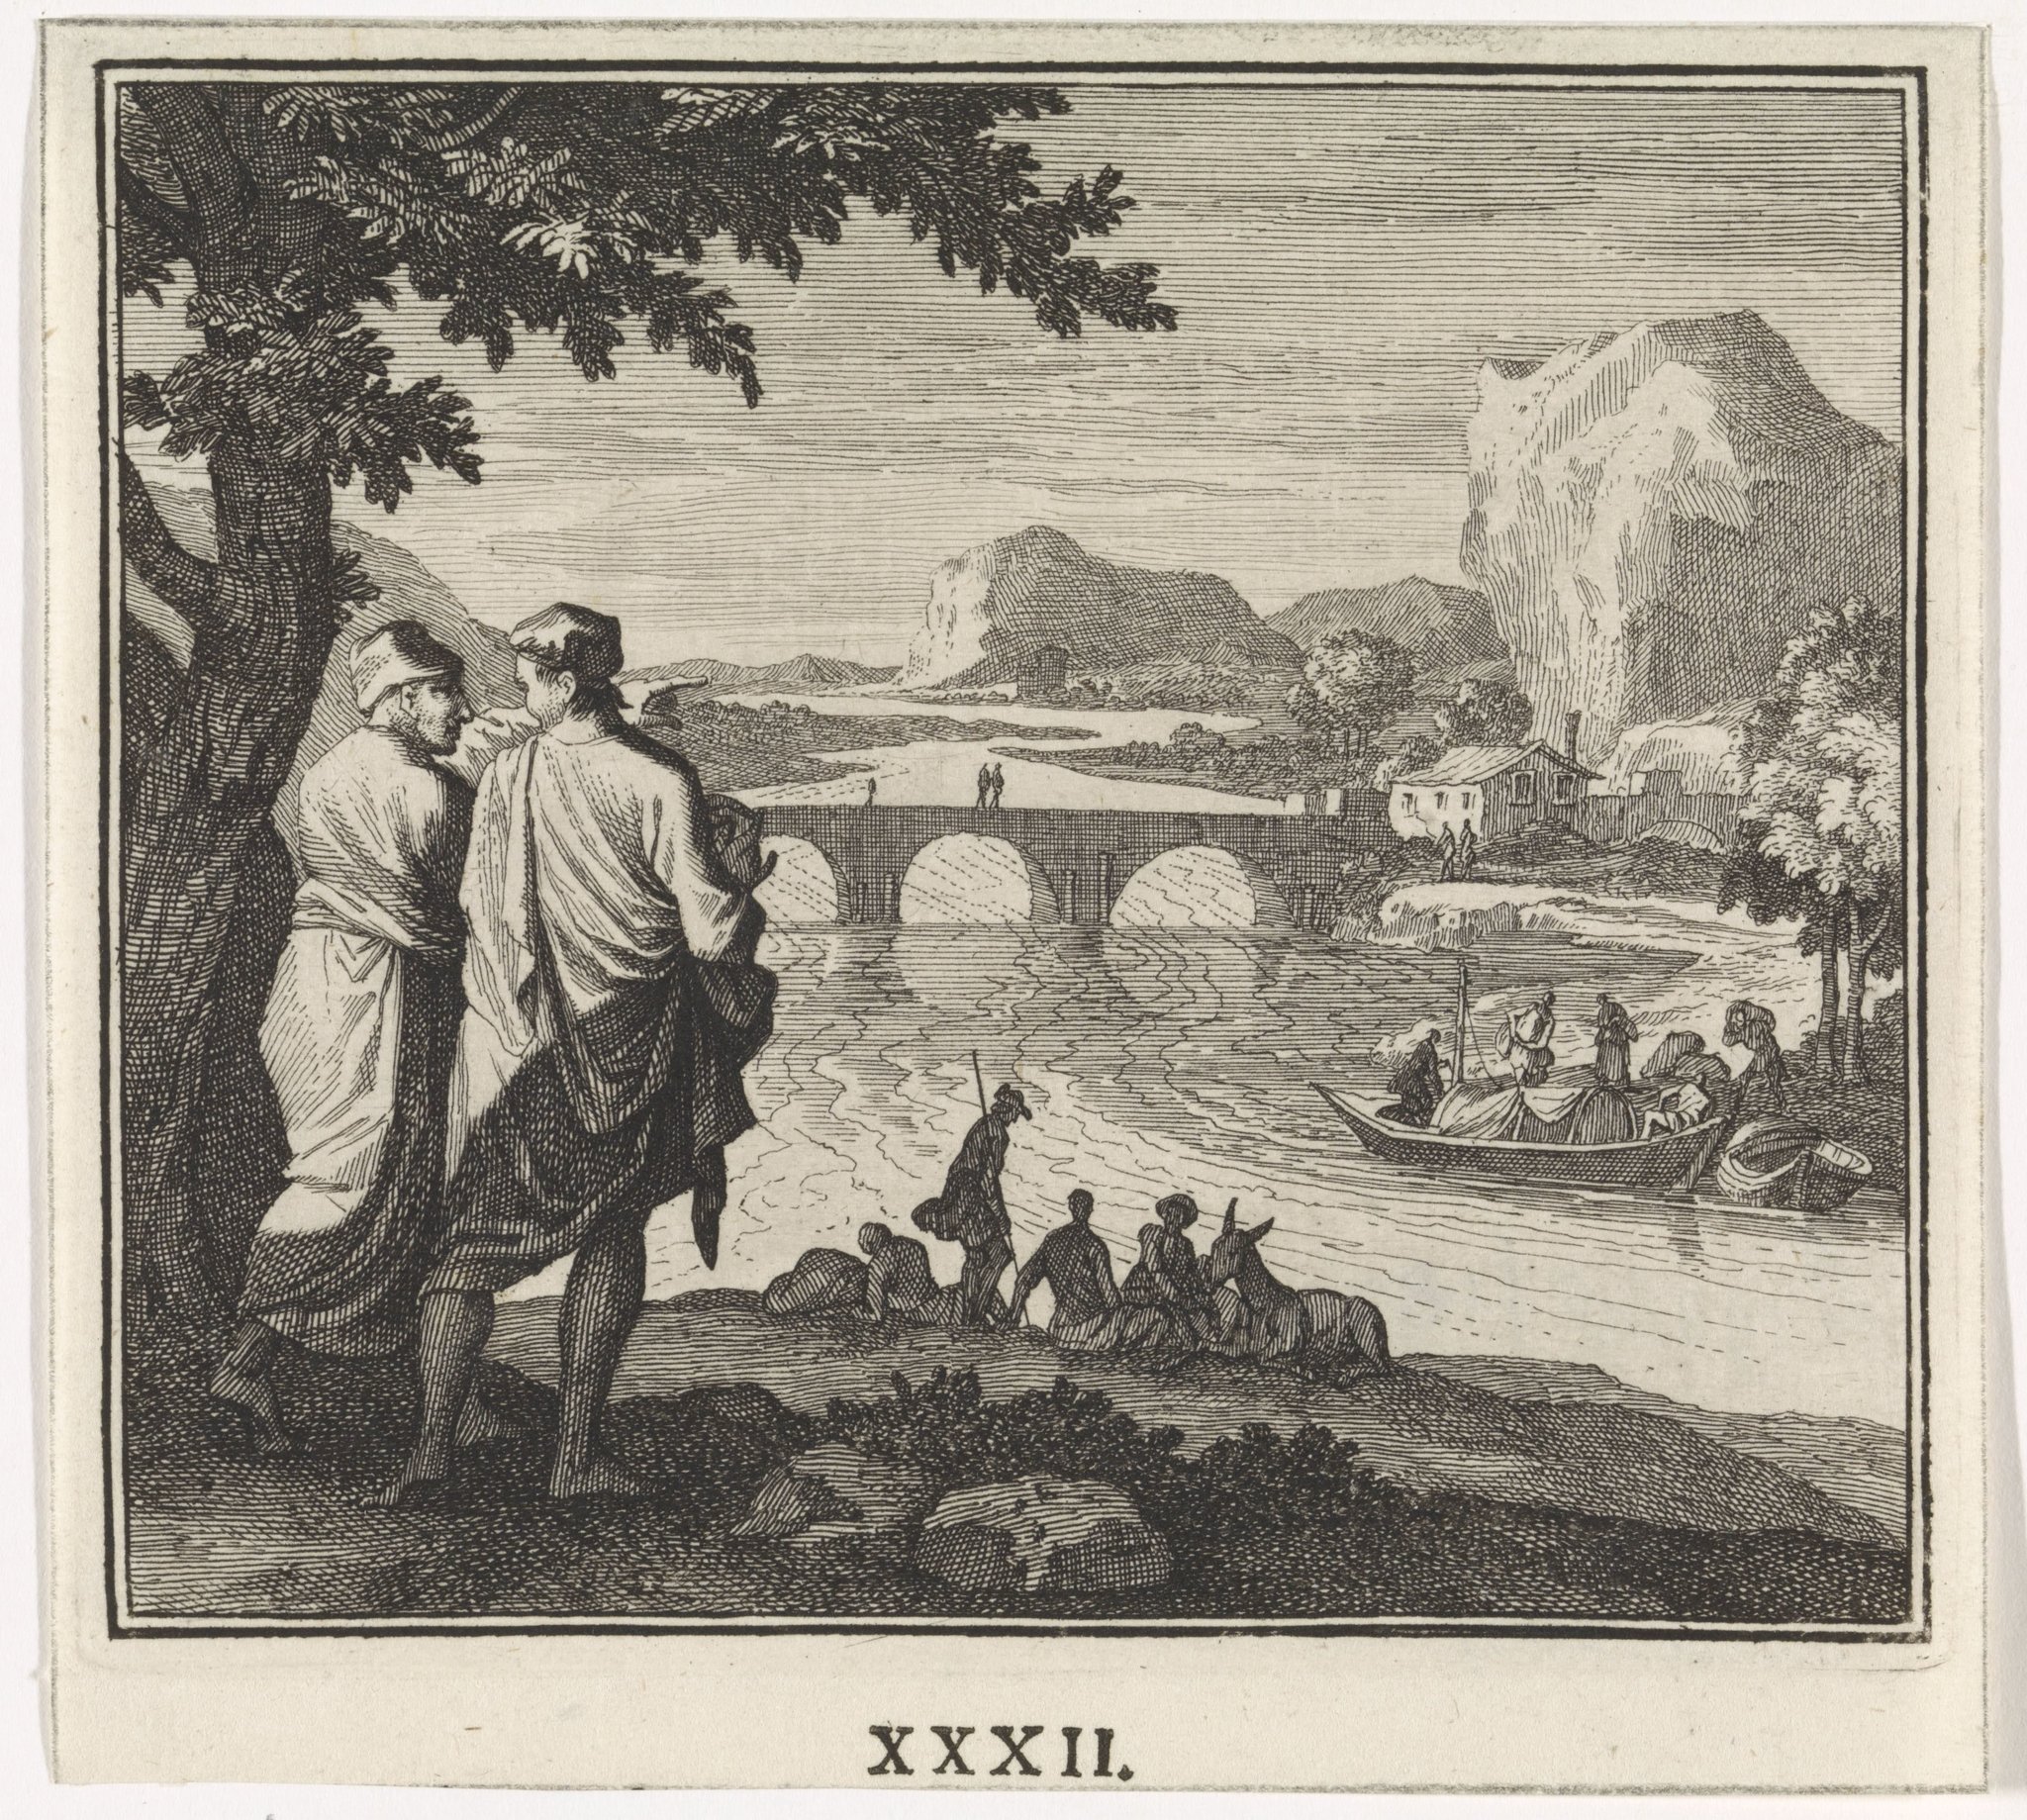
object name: book illustration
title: Twee mannen bij een rivier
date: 1695-1705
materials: paper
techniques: etching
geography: nuremberg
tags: adult man (+ two persons), landscape with bridge, viaduct or aqueduct (+ city(-scape) with figures, staffage), bridge in village across river, canal, etc., abstract ideas and concepts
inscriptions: collector's mark: Lugt 2228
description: Boekillustratie voor Weigel, Christoph. Ethica Naturalis seu Documenta Moralia e Variis rerum Naturalium proprietatibus Virtutum Vitiorumq symbolicis imaginibus collecta. Neurenberg: Christoph Weigel: c. 1700.